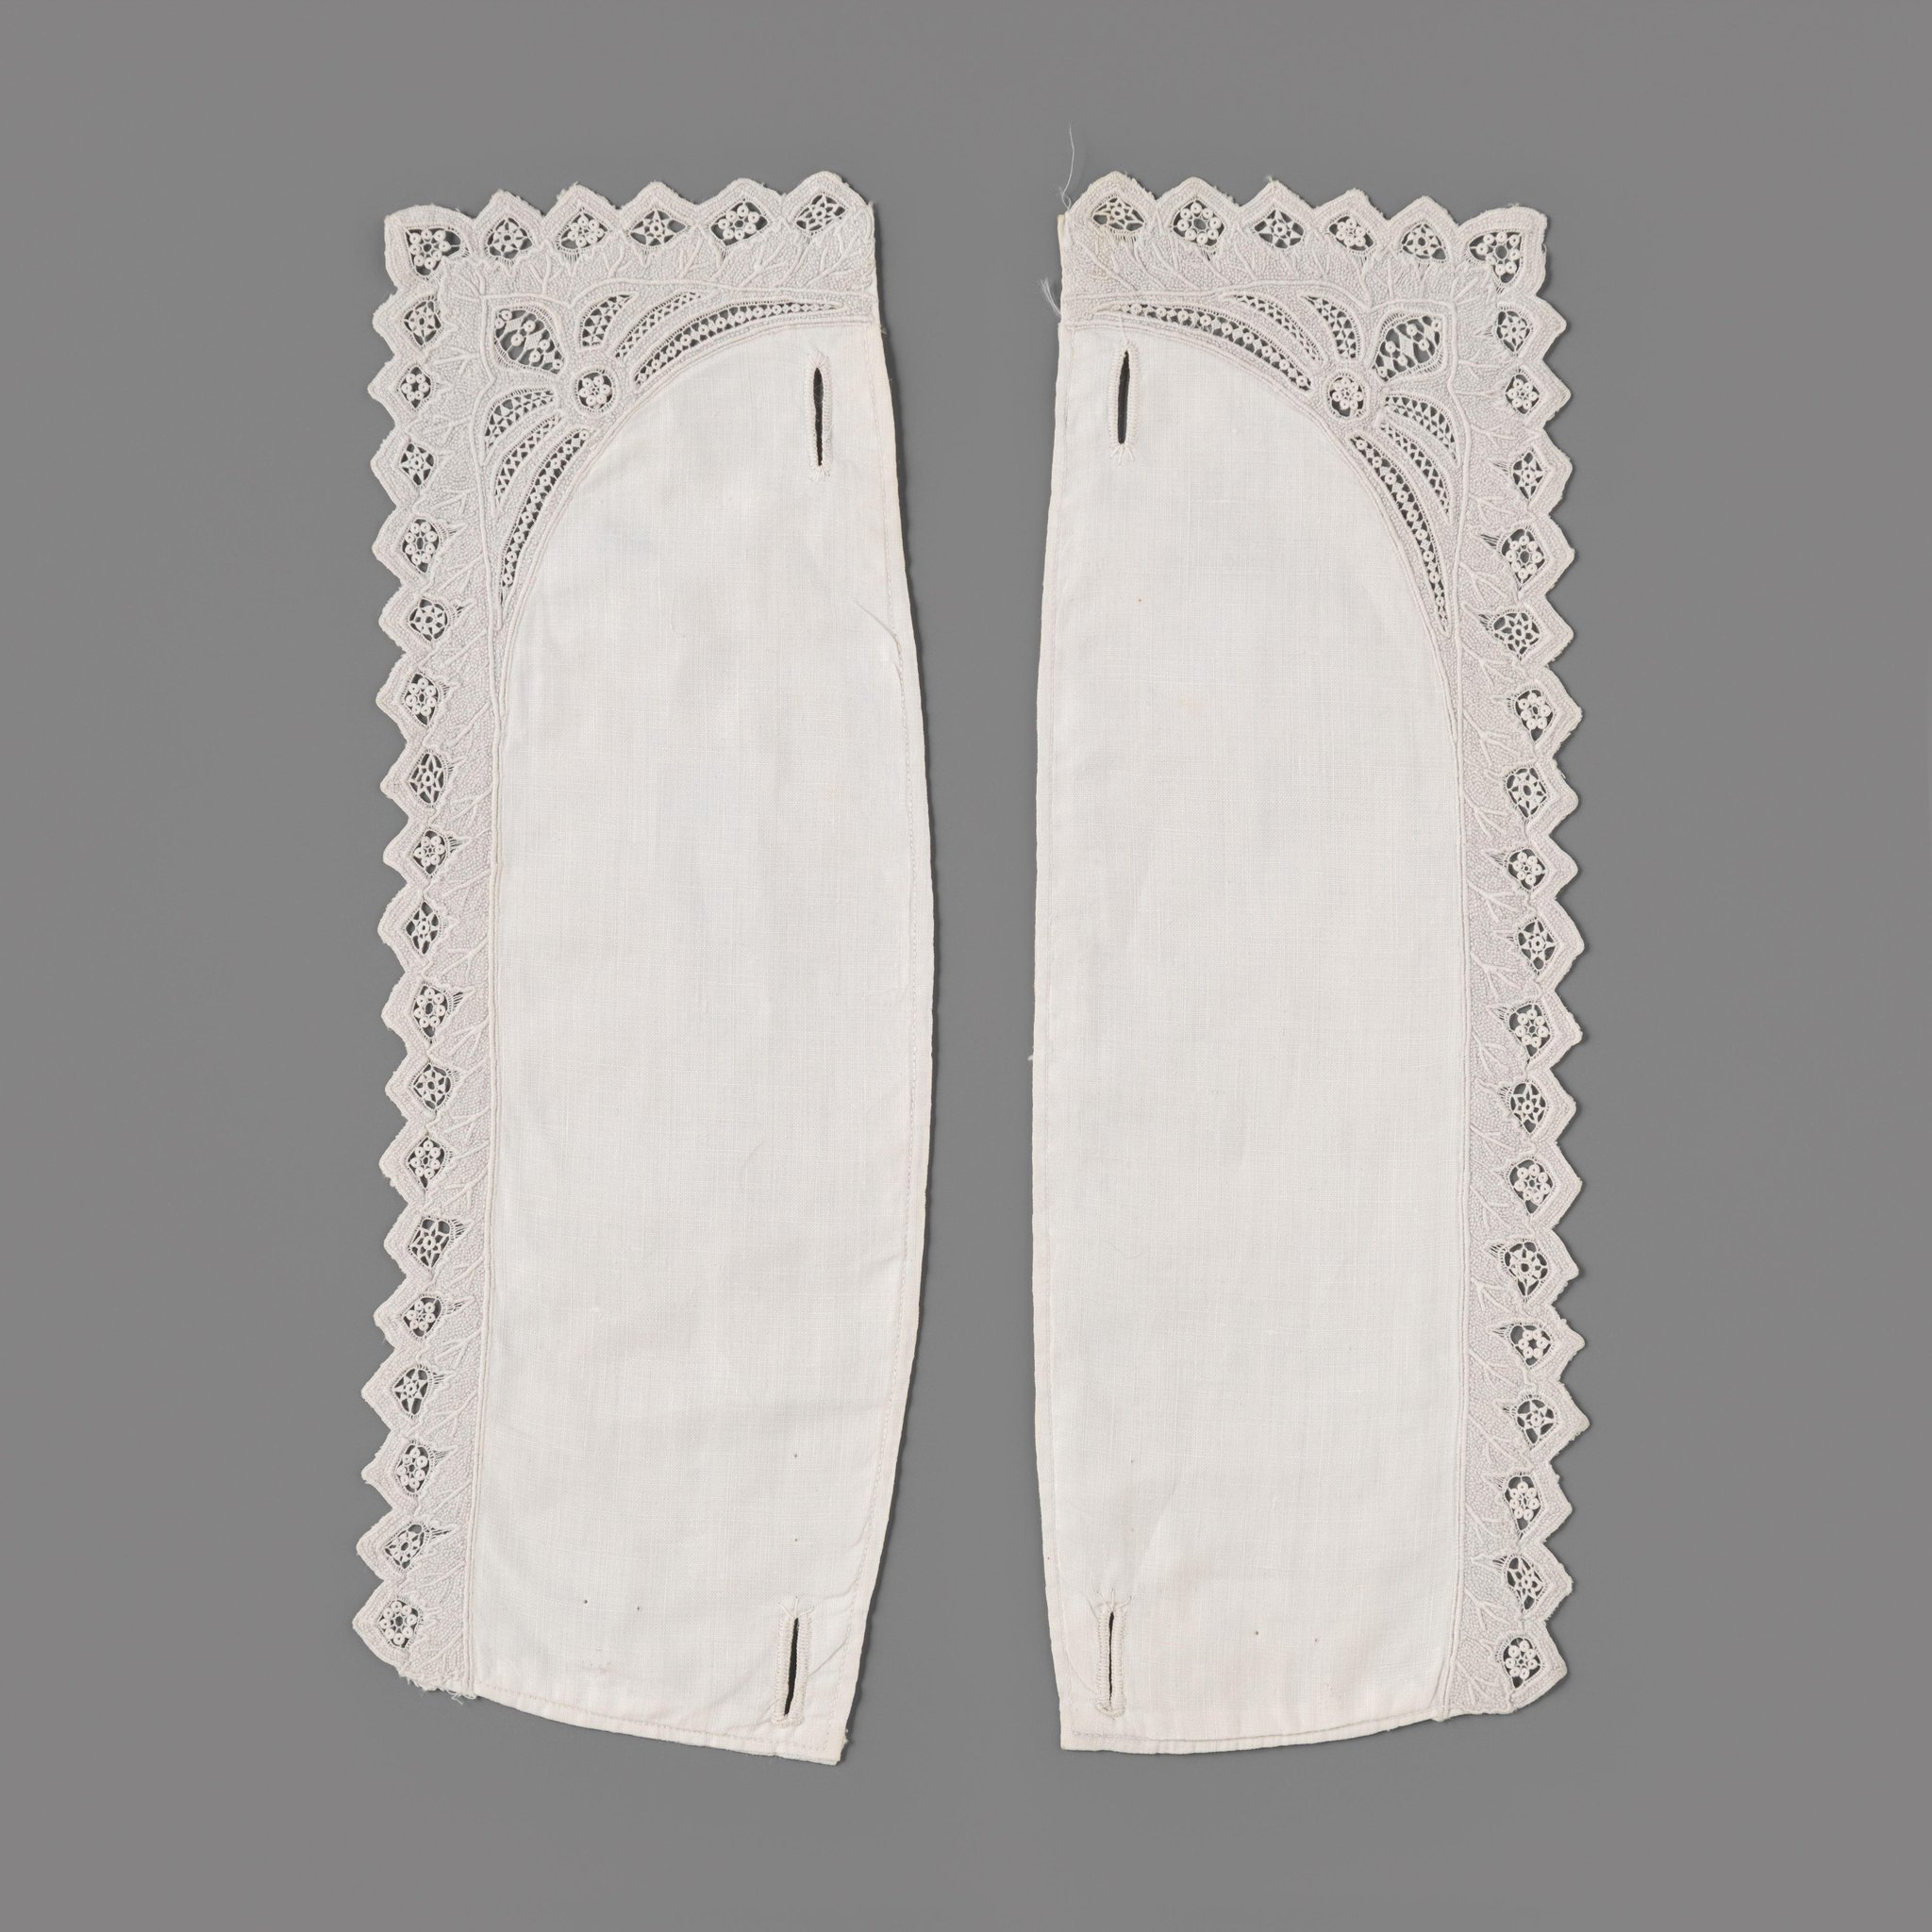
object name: womenswear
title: Manchet van linnen batist versierd met borduurwerk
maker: Anonymous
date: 1850-1900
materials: linen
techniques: embroidered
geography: western europe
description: Manchet van linnen batist, aan twee zijden versierd met een kartelrand van borduurwerk en naaldkant in de vorm van bladeren. In de hoek tussen deze twee zijden een bladmotief. De manchet is gevoerd.